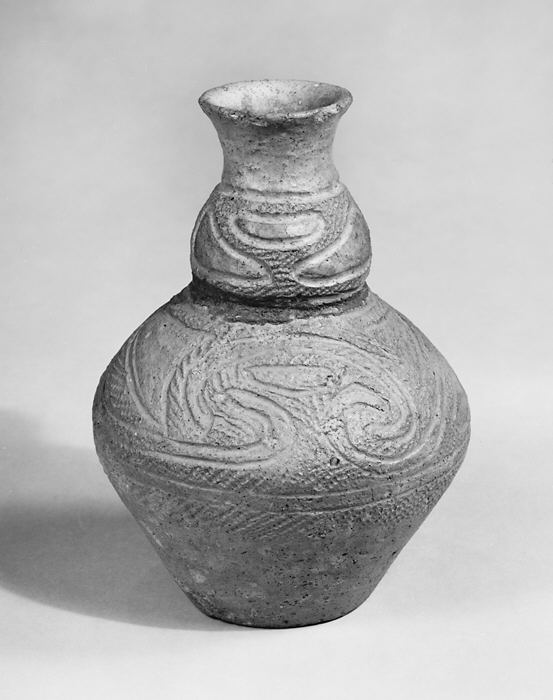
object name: jar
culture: japanese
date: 100 BCE-100 CE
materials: cord, earthenware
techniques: incising